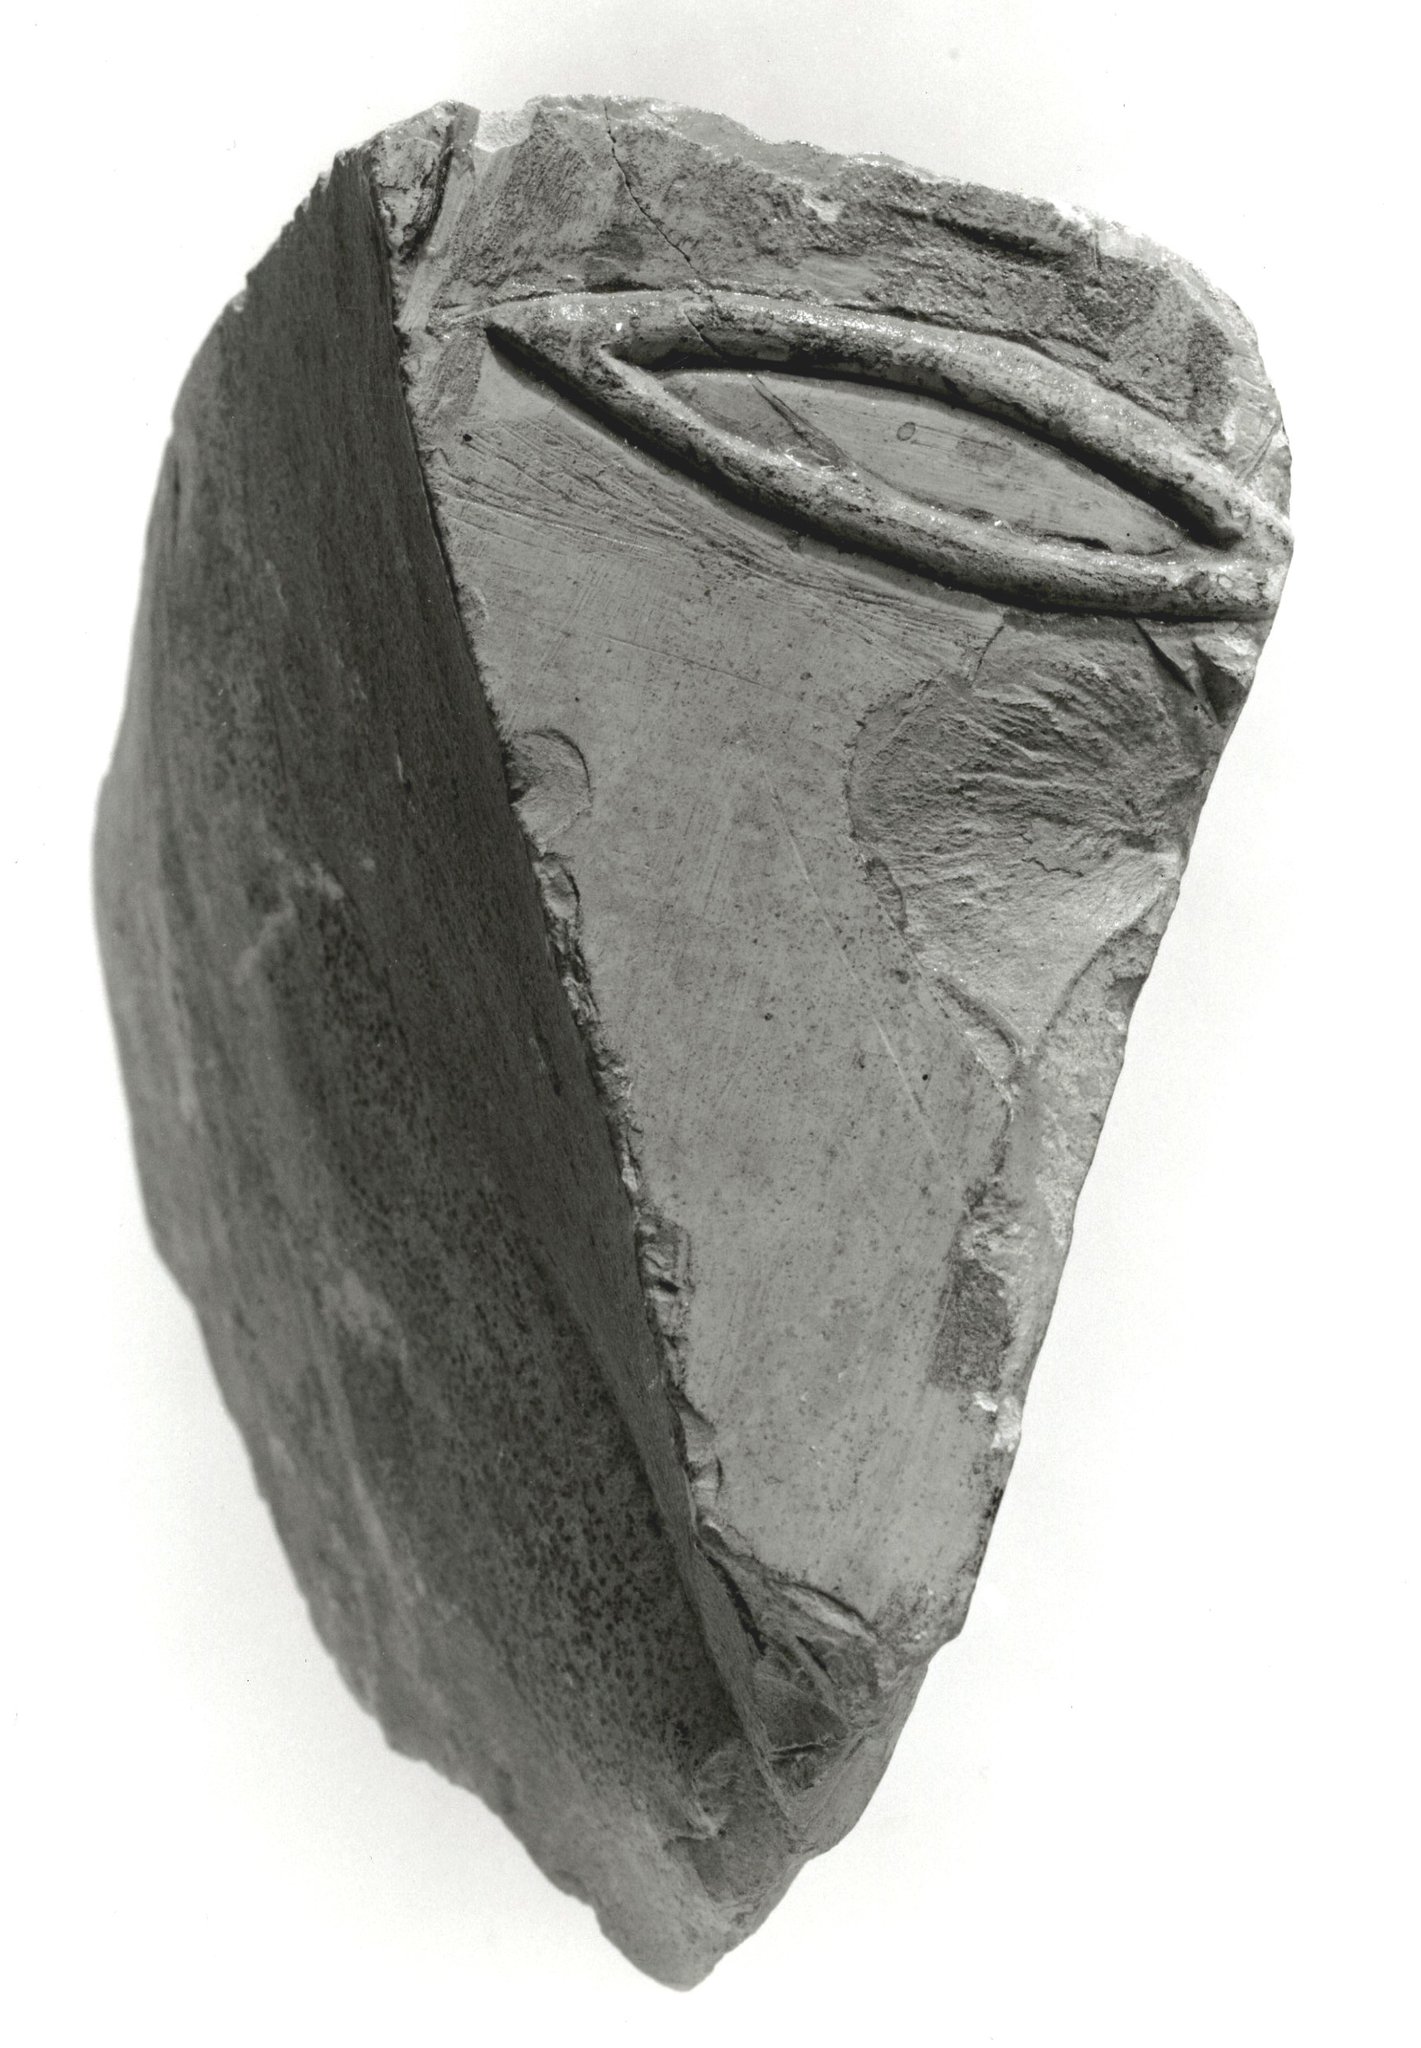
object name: relief, tomb of nespekashuty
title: Raised relief fragment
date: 664-610 BCE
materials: limestone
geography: egypt